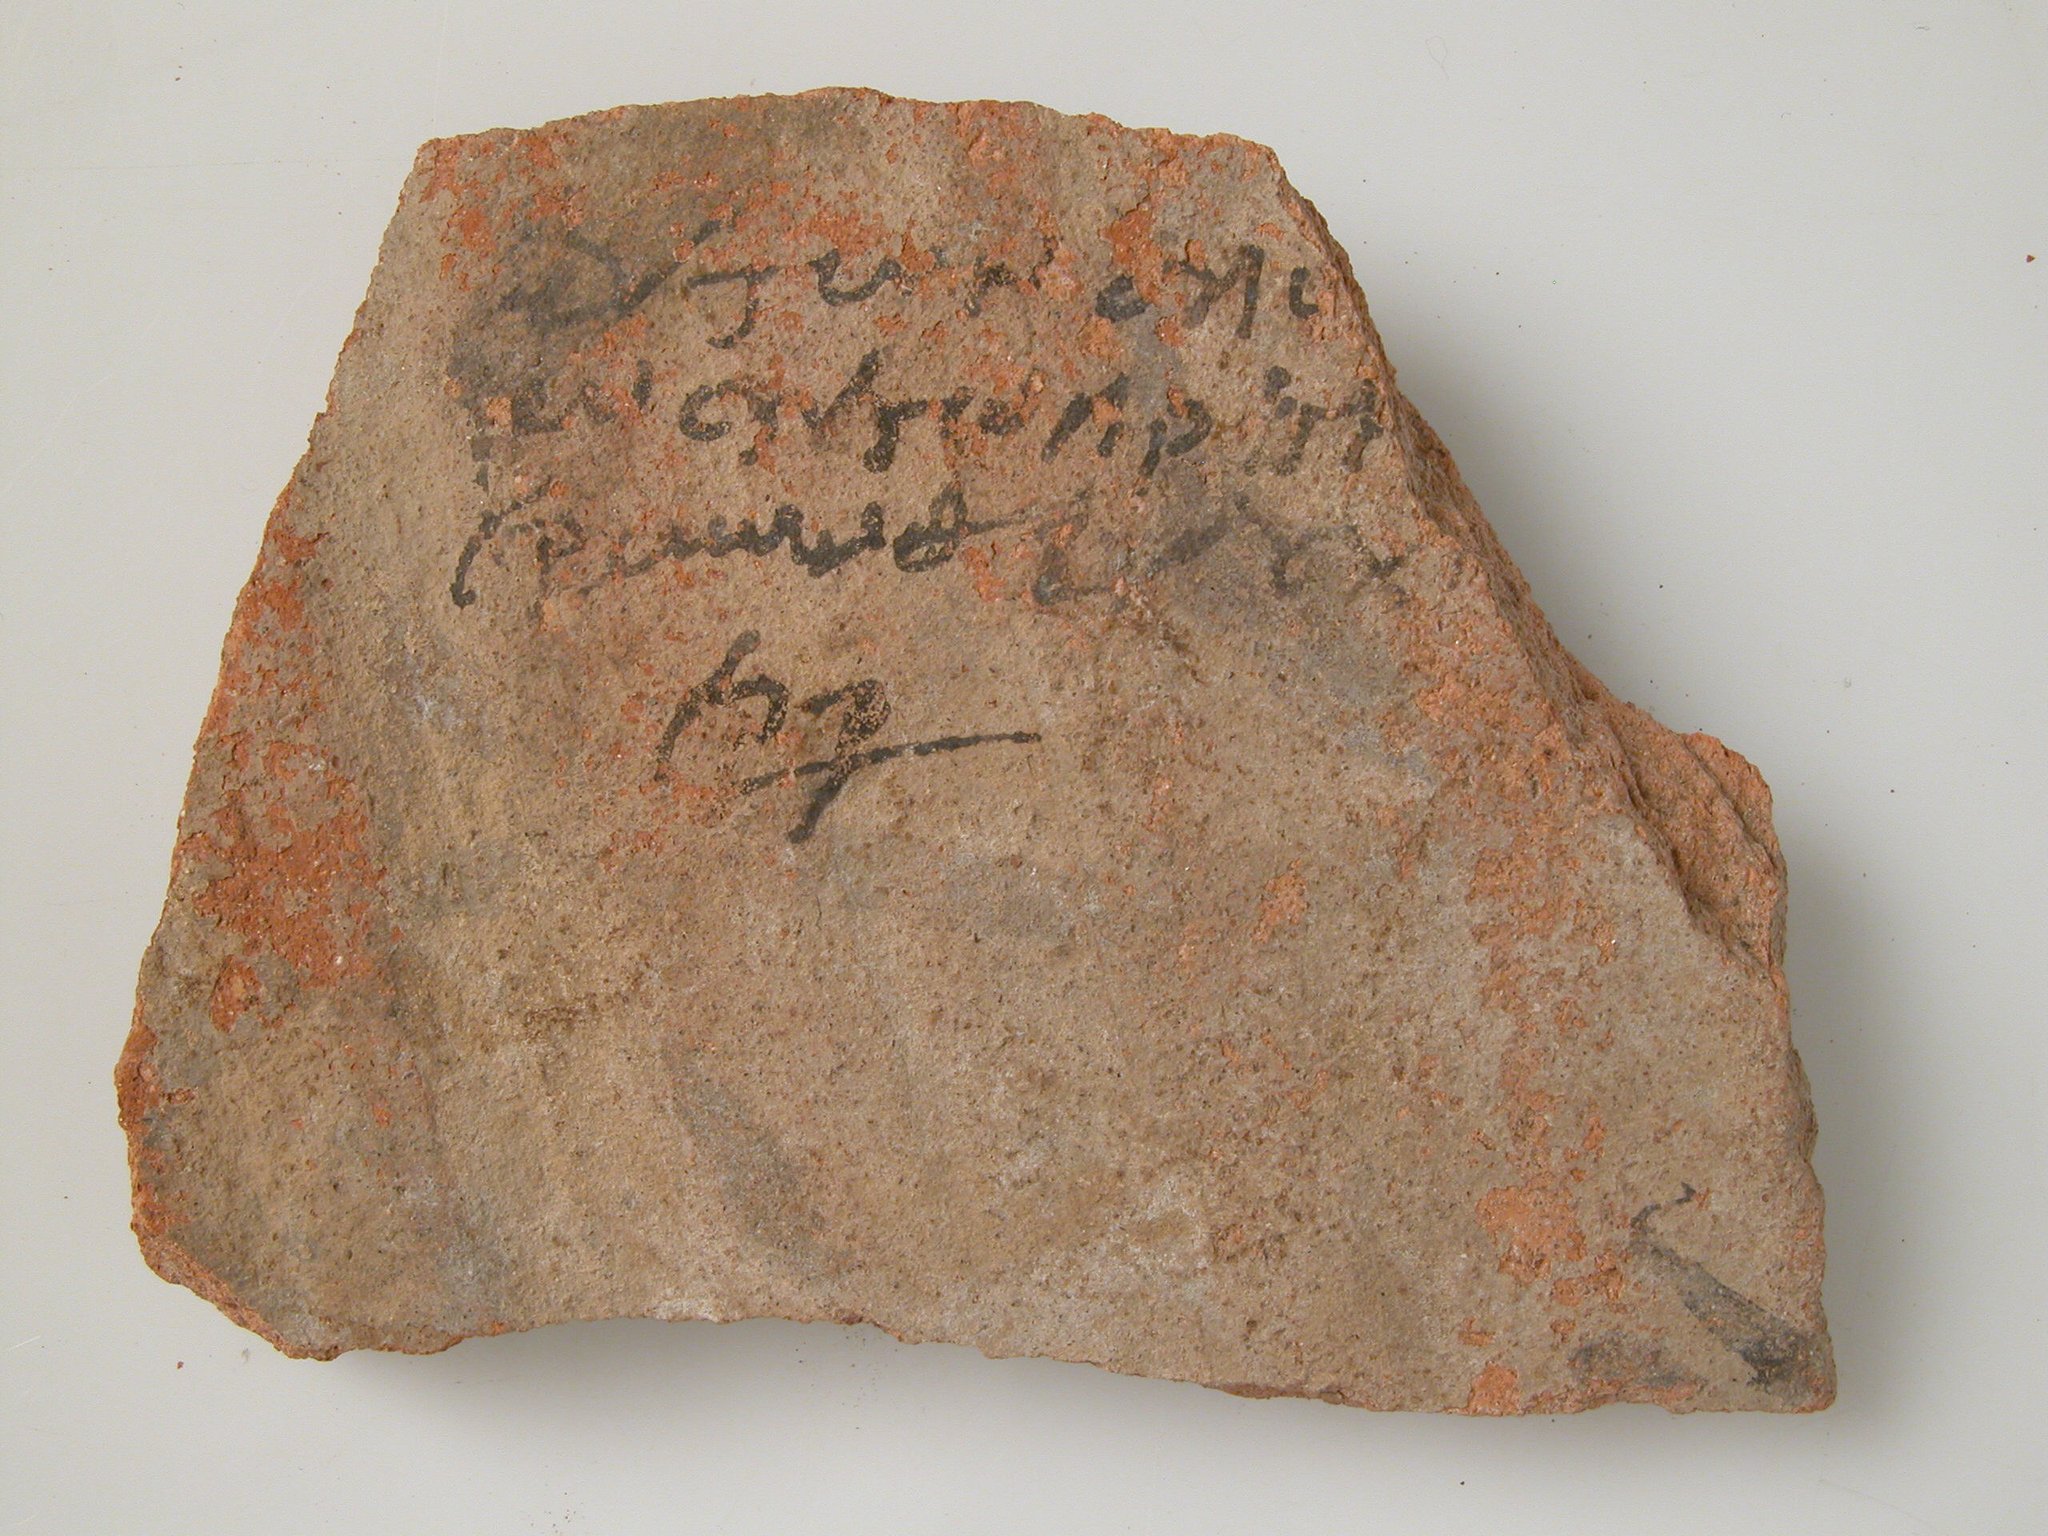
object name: ostrakon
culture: coptic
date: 301-700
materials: ink, pottery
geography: egypt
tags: documents